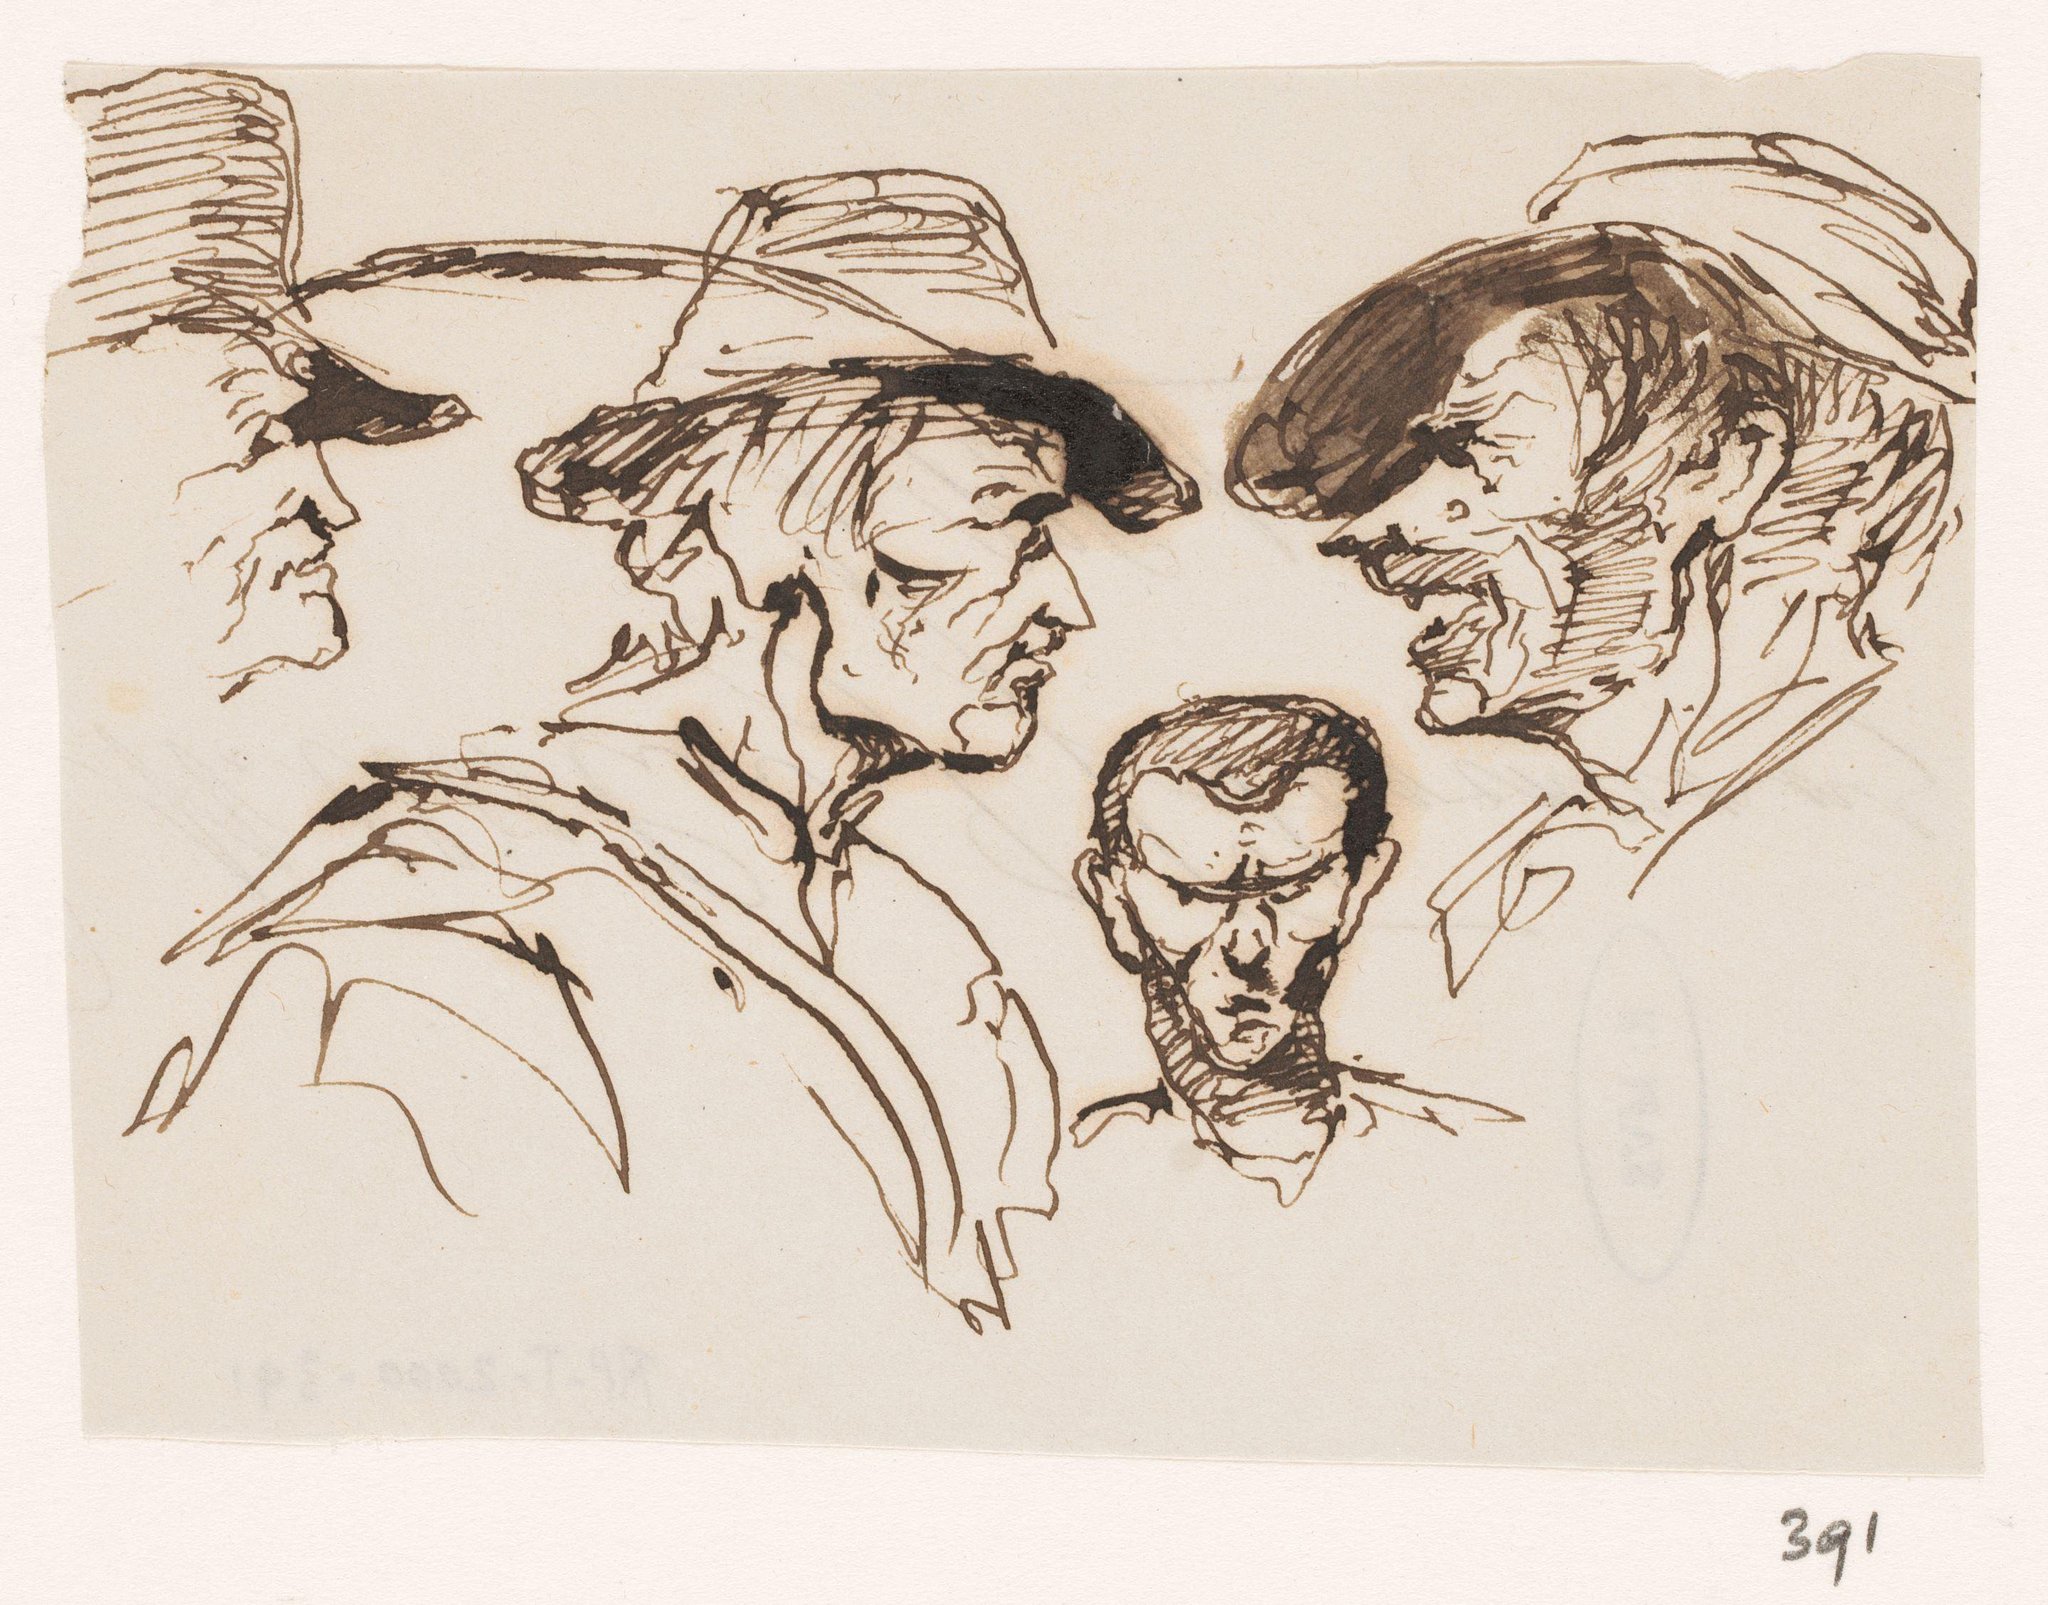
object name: drawing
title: Vier koppen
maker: johannes tavenraat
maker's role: draughtsman, painter, print maker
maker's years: 1809-1881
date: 1840-1880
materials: ink, paper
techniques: pen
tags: caricatures (human types)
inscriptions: collector's mark: Lugt 2228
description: Vier koppen. Getekend op de achterzijde van een deel van een envelop gericht aan Tavenraat.